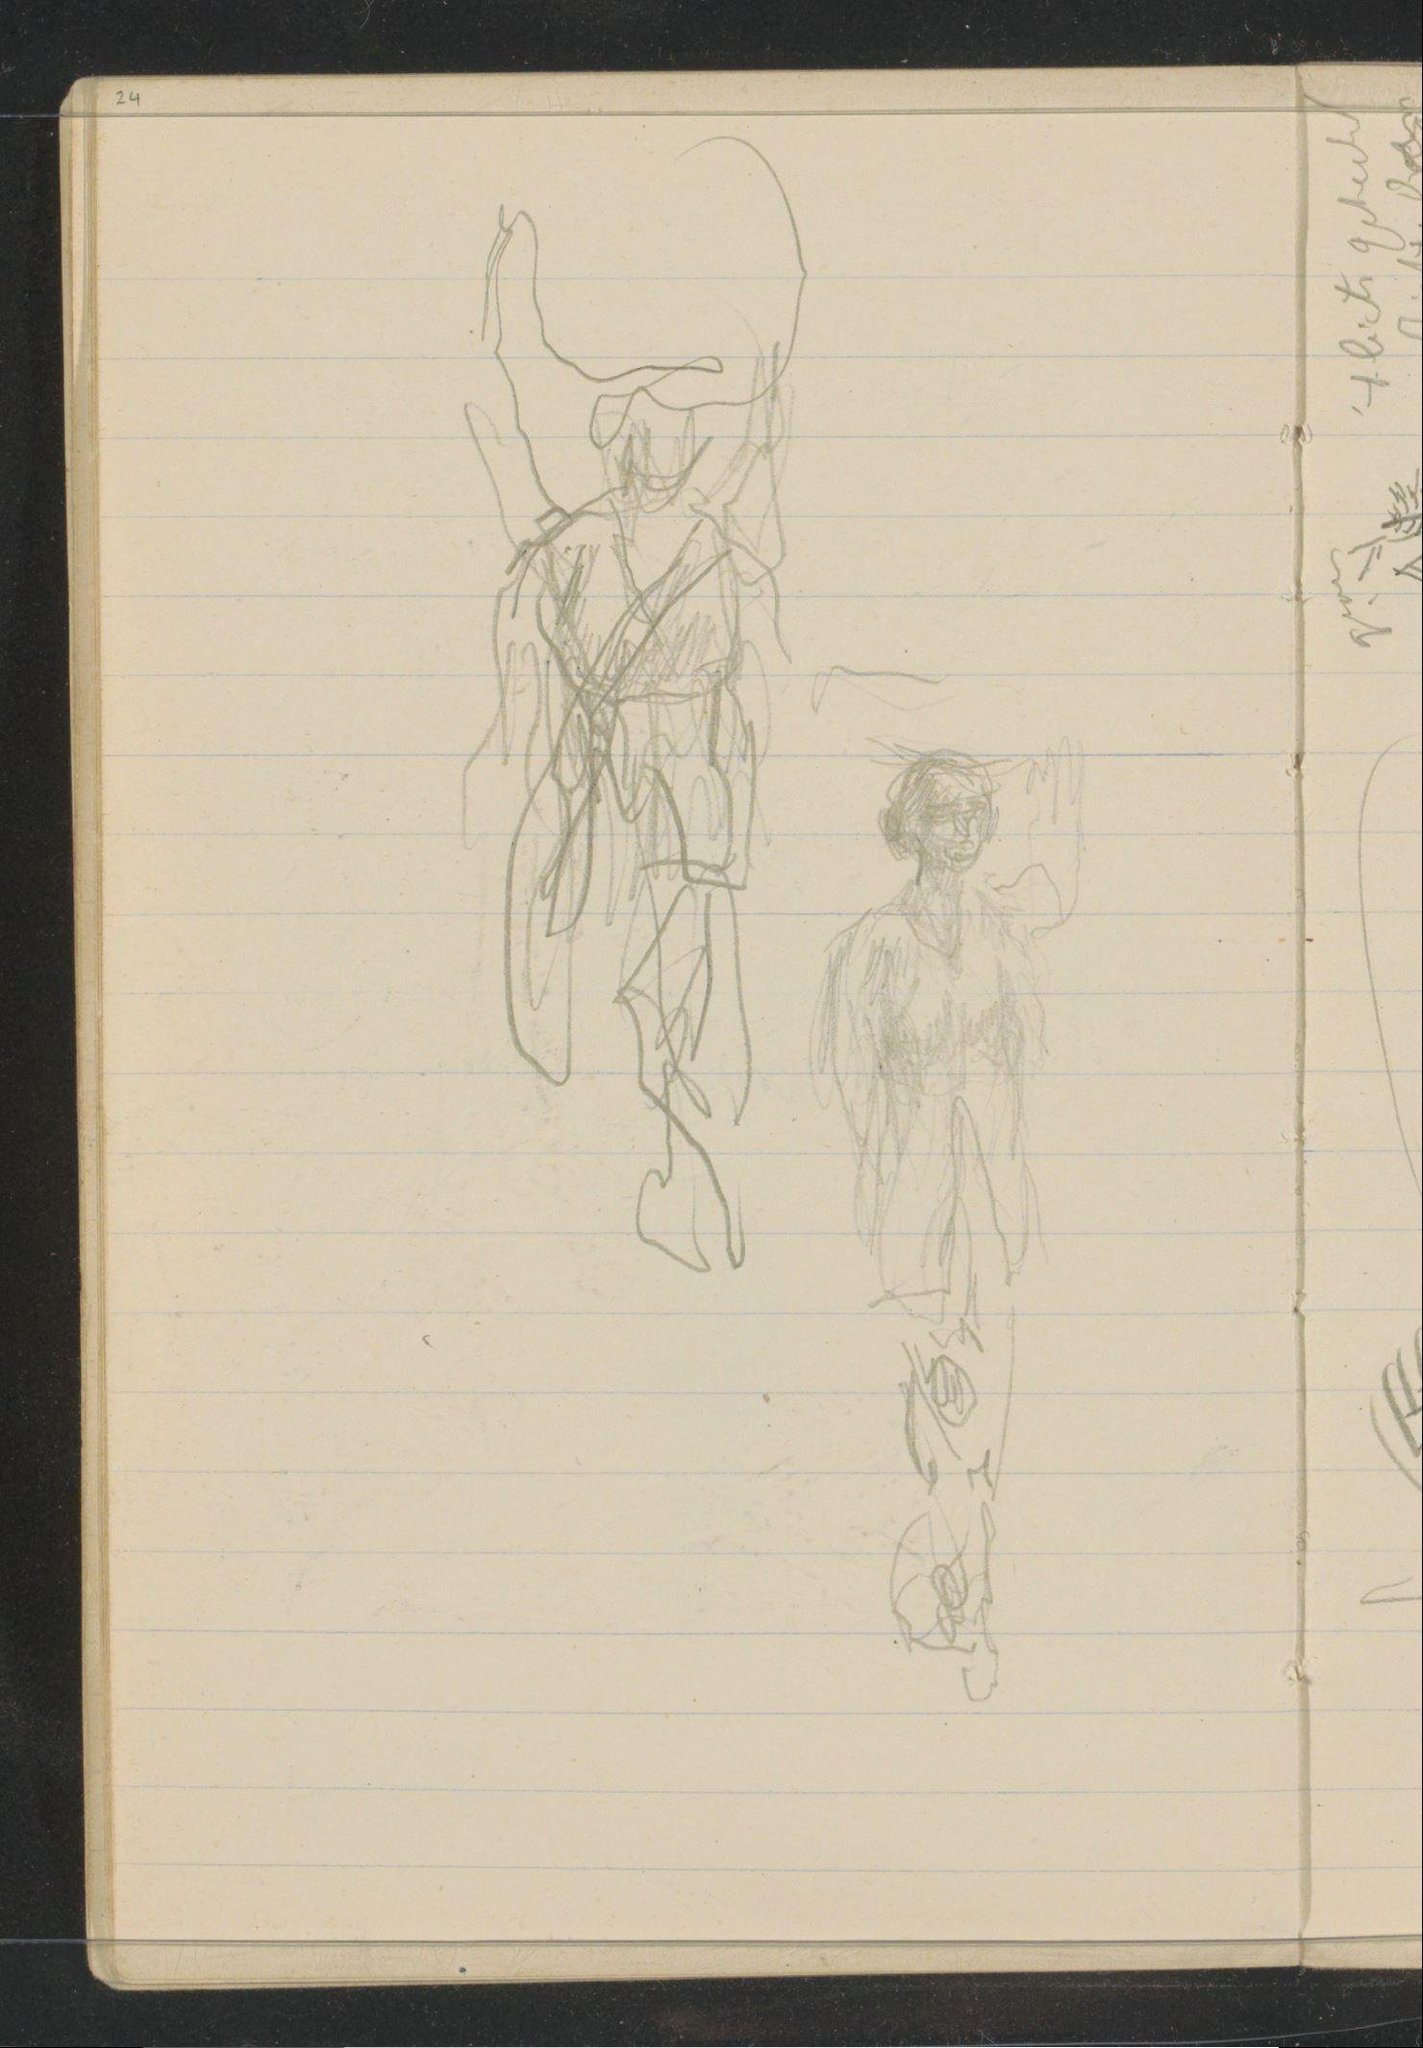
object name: sketchbook leaf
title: Indonesiërs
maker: marius bauer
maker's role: draughtsman, print maker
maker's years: 1867-1932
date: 1931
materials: pencil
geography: java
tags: asiatic races and peoples, folk costume, regional costume, carrying something on the head or on the shoulders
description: Onder andere een vrouw die een schaal op haar hoofd draagt. Pagina 24 uit een schetsboek met 74 bladen.